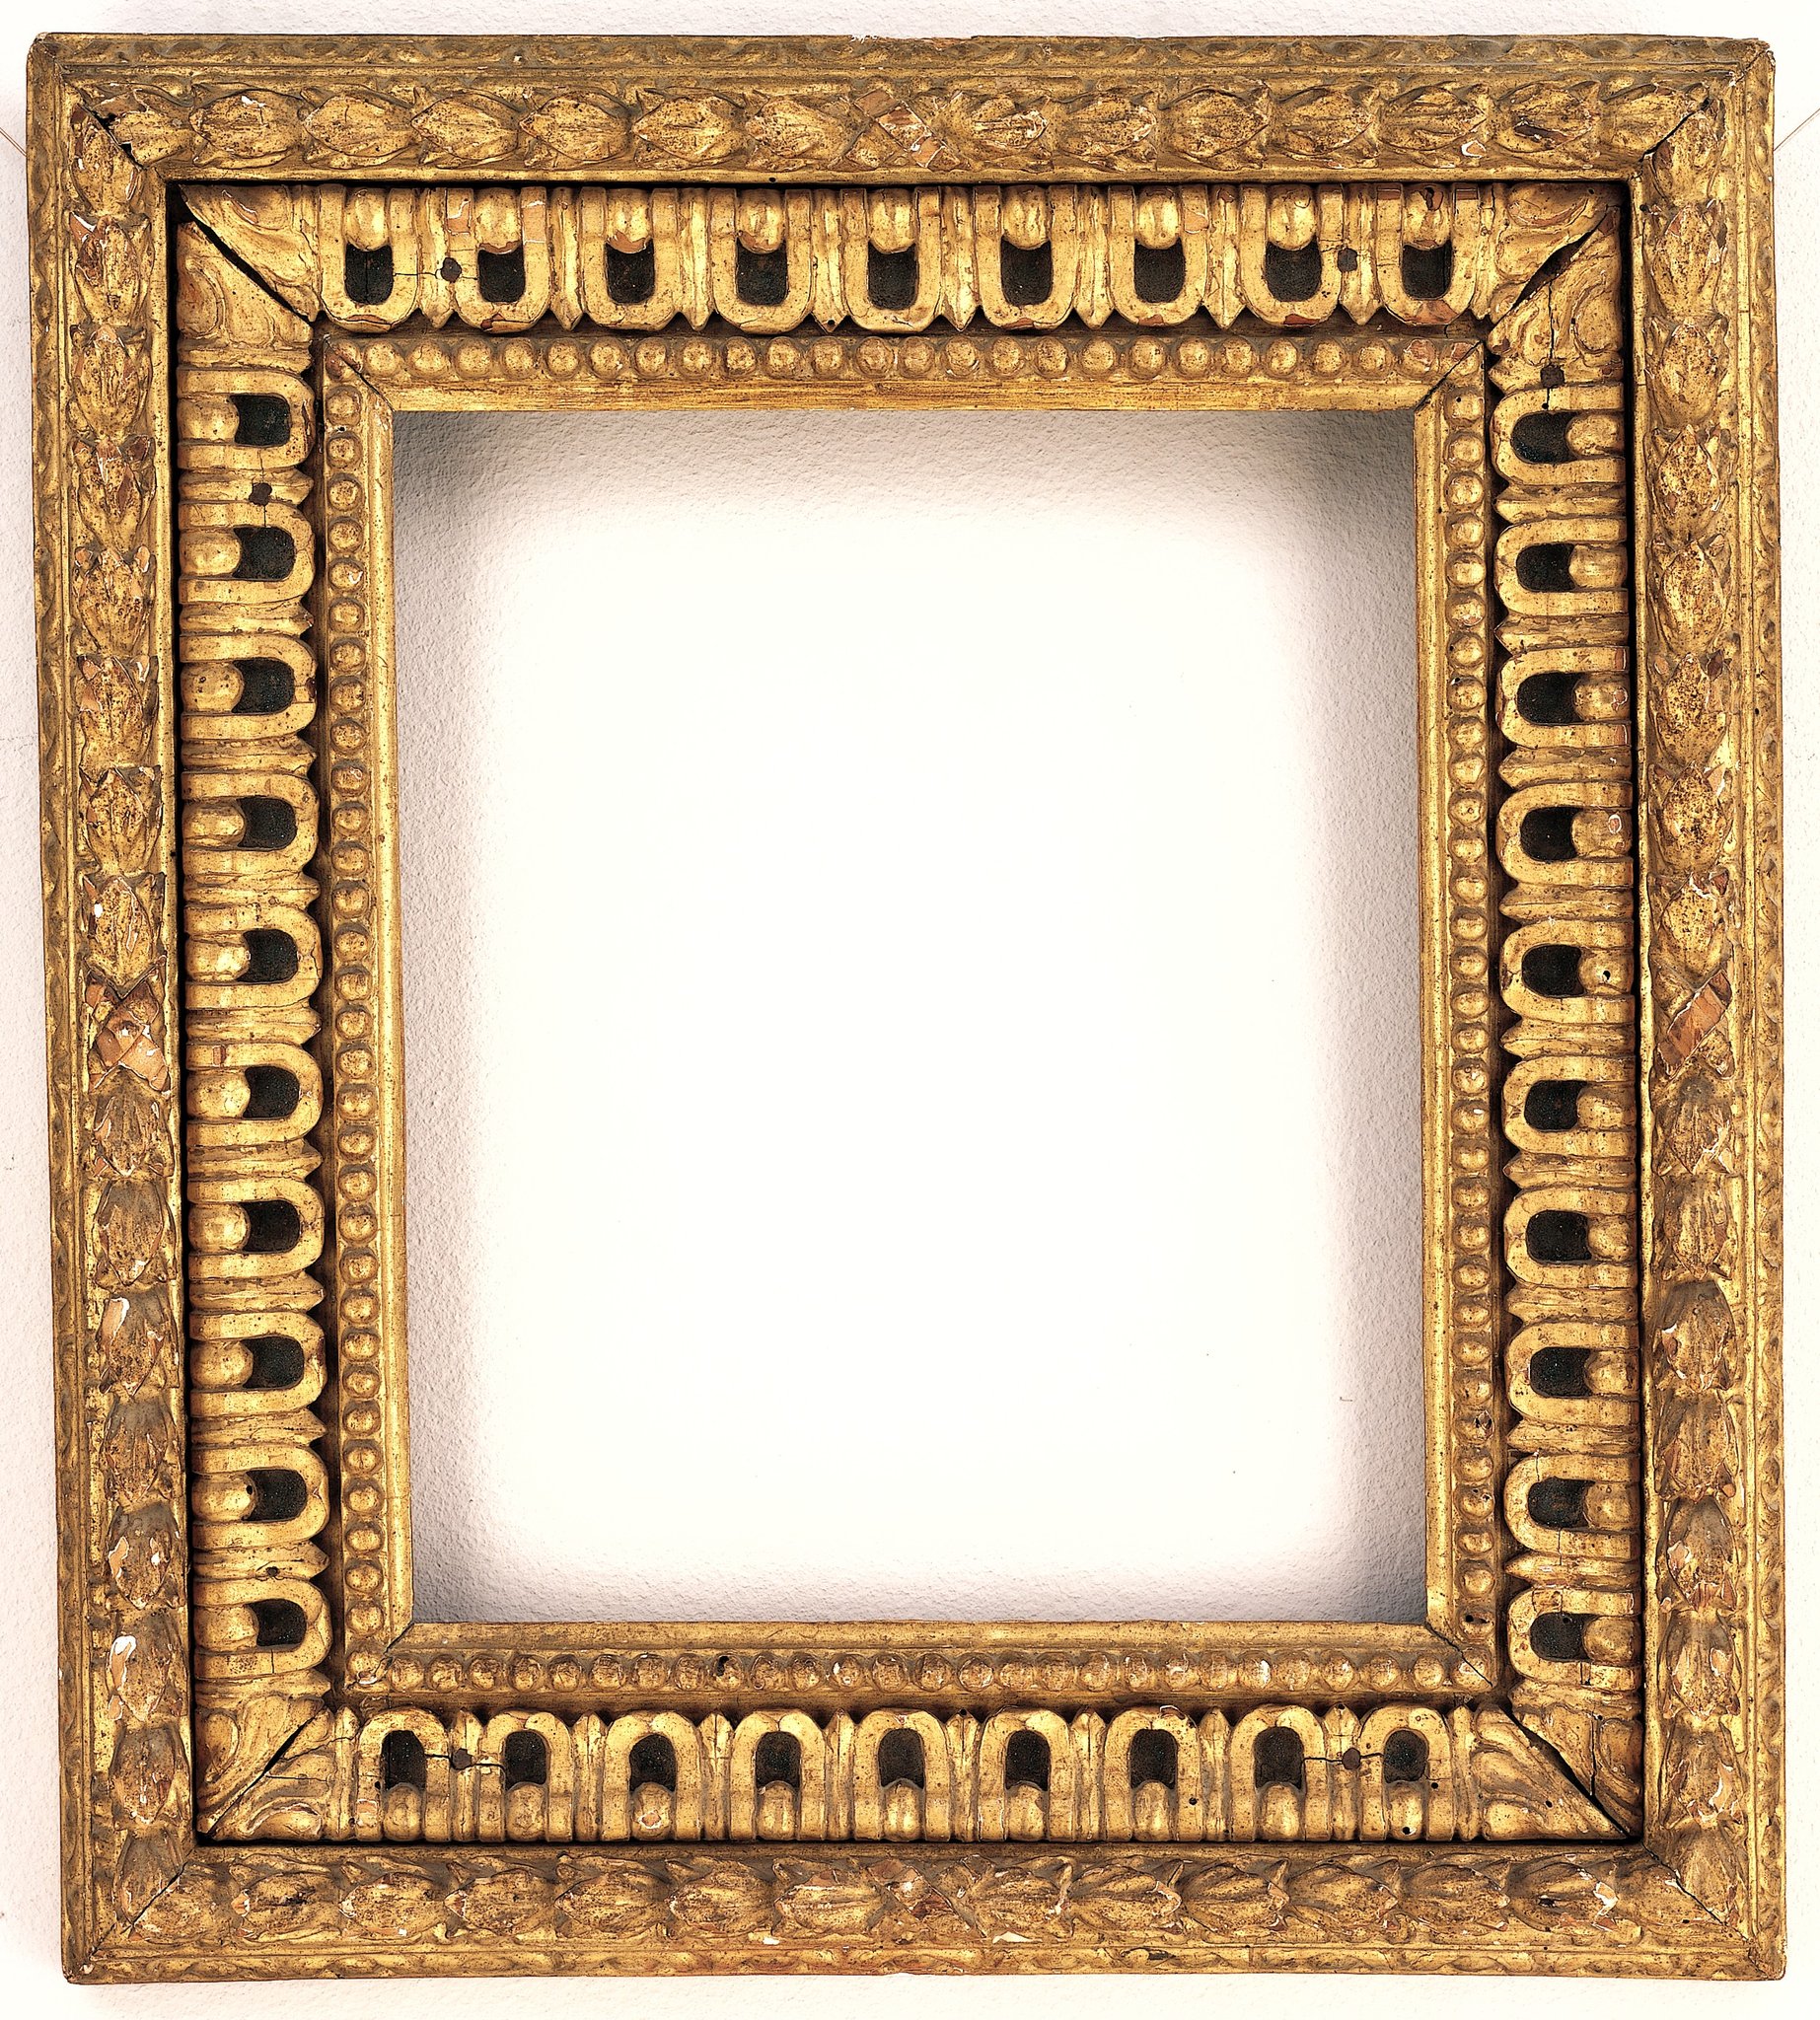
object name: frame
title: Cassetta frame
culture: italian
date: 1575-1580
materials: wood